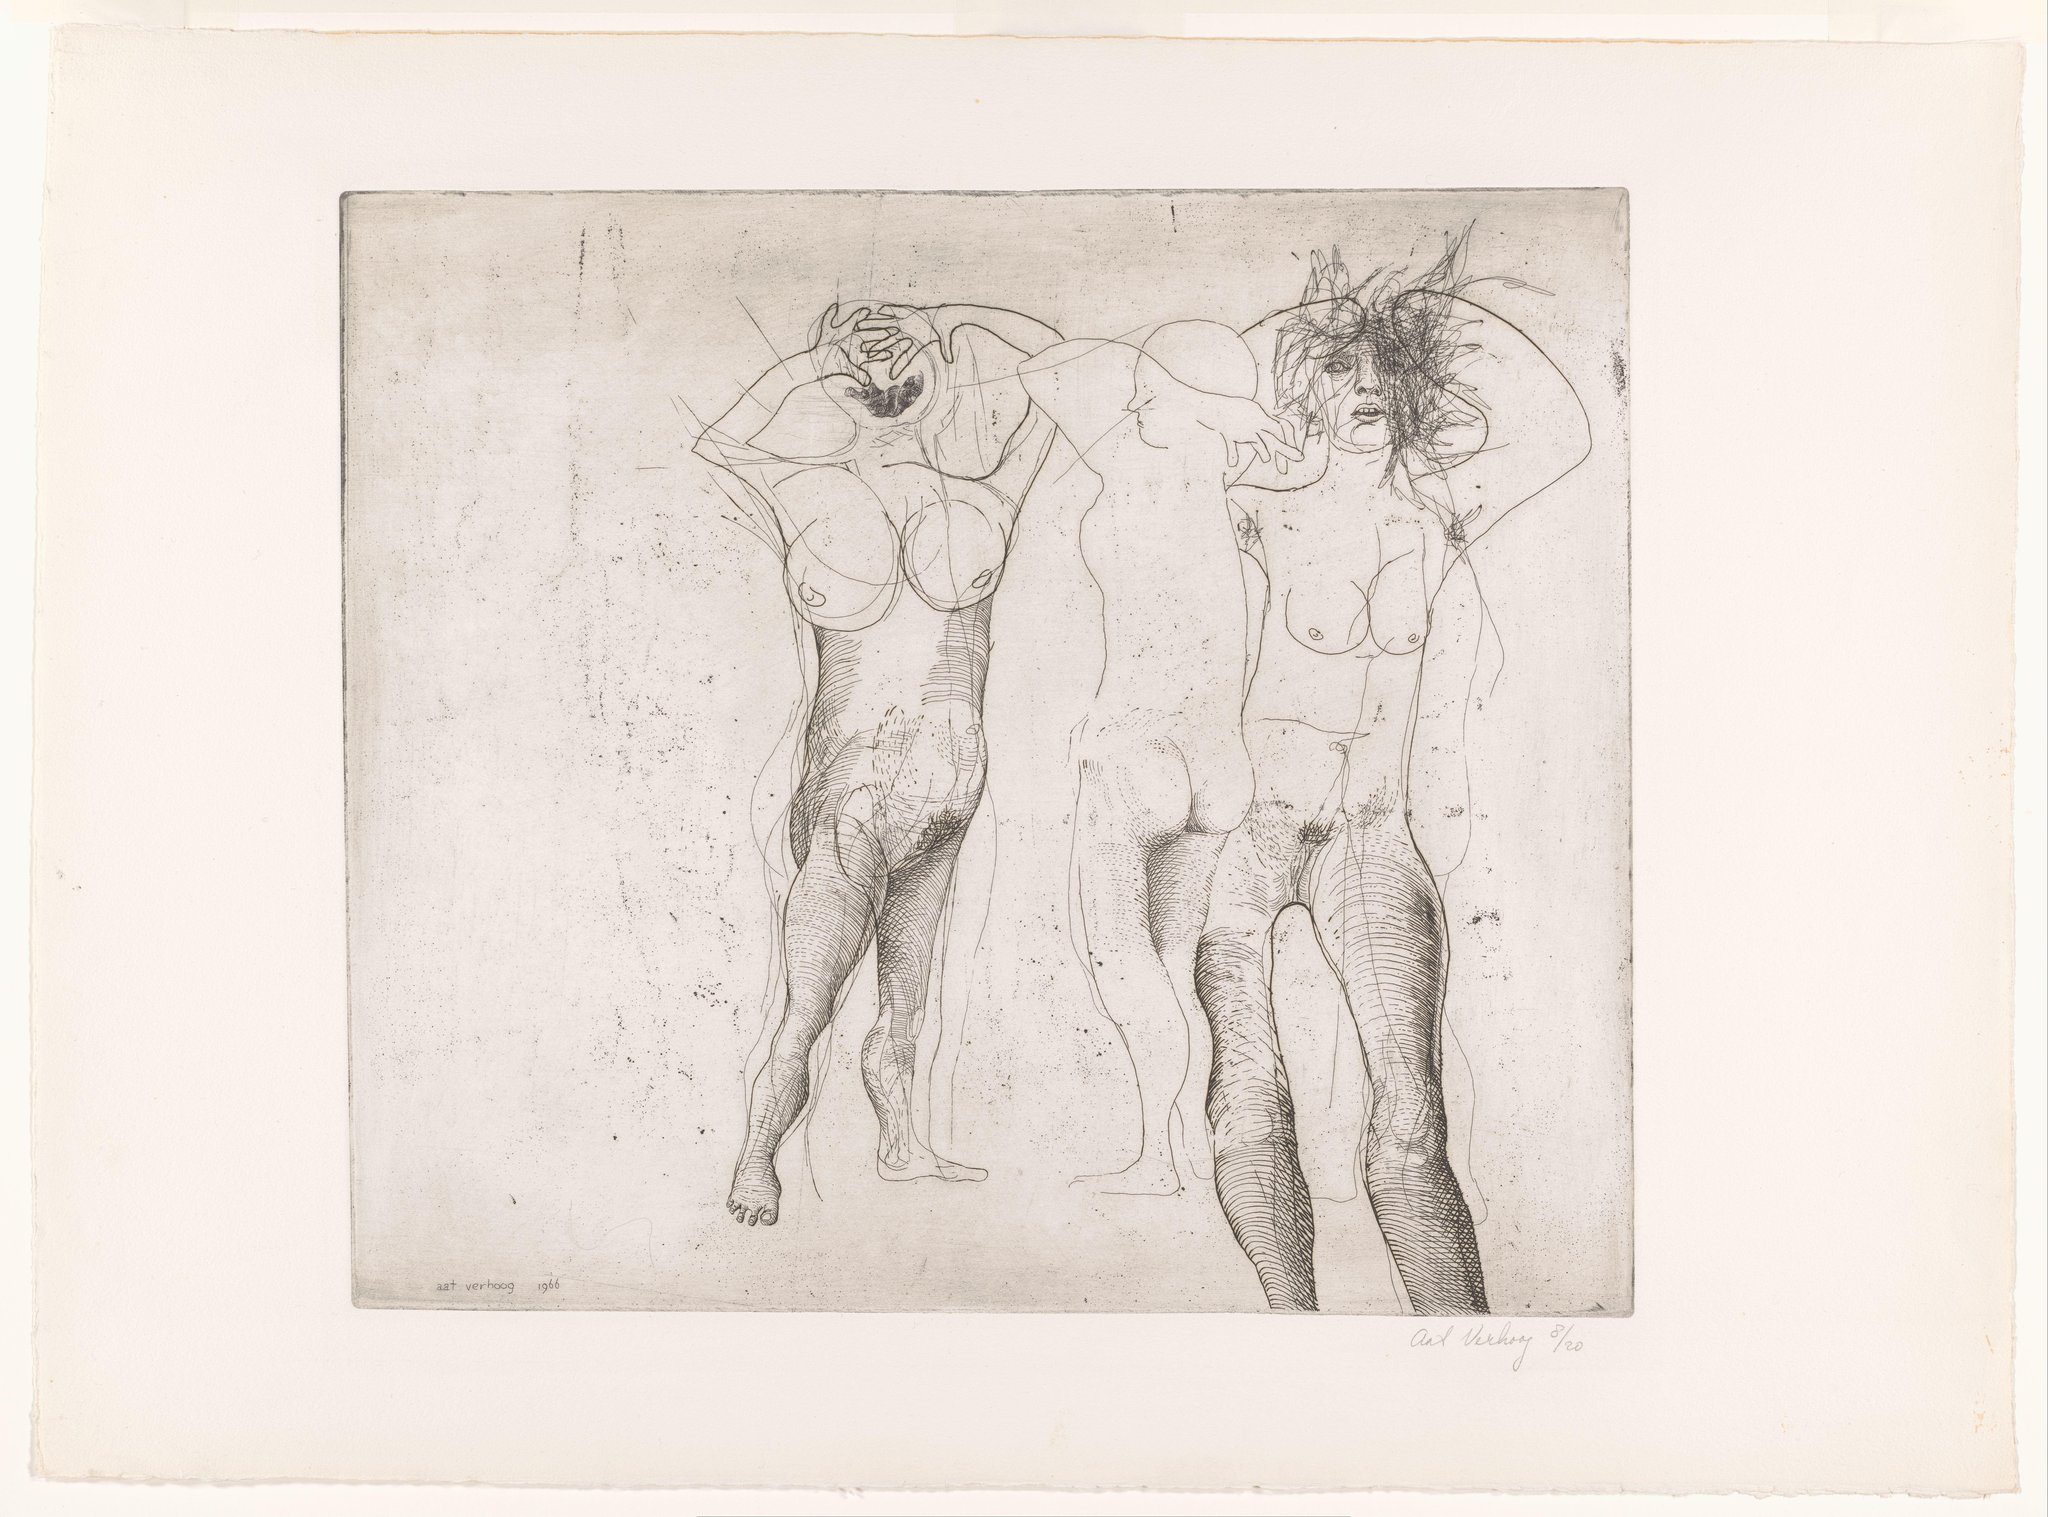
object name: print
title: 3 figuren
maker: aat verhoog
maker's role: print maker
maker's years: 1933-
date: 1966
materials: paper, ink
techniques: etching, intaglio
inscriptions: signature and date: ‘aat verhoog 1966’, edition: ‘8/20’, signature: ‘Aat Verhoog’, title: ‘" 3 figuren "’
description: Drie staande gedeformeerde vrouwelijke naakten, de middelste op de rug gezien, met de handen achter hun hoofd.